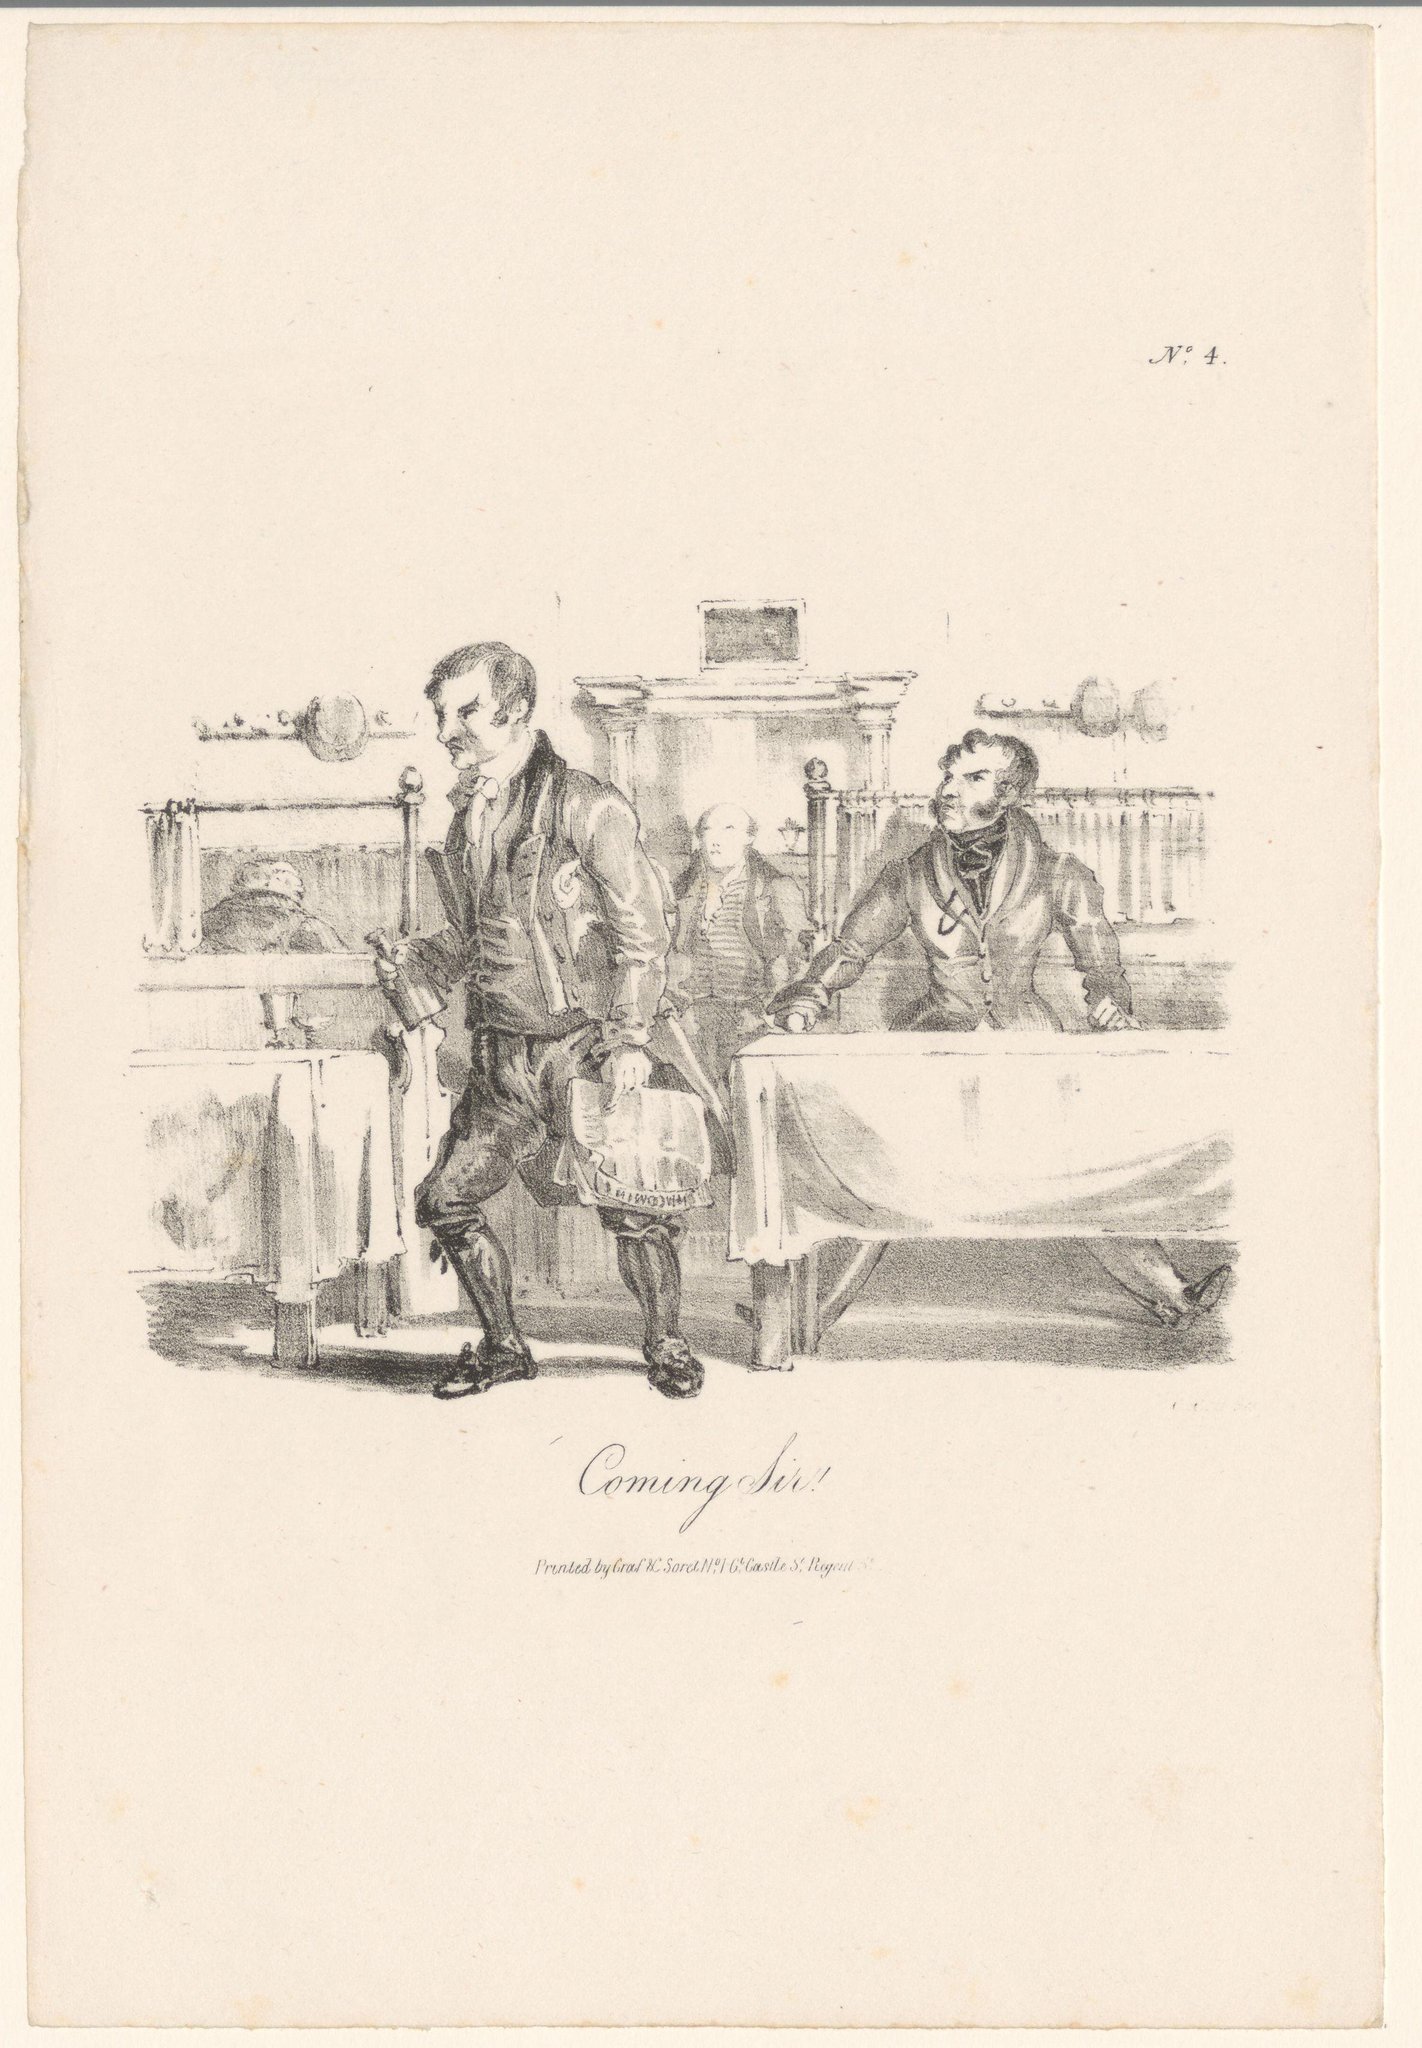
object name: cartoon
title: Diverse spotprenten over de Engelse bevolking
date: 1830-1838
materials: paper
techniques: lithograph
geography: london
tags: container of glass: bottle, jar, vase, restaurant, newspaper, news-sheet, political caricatures and satires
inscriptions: collector's mark: Lugt 2228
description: Prent maakt deel uit van een serie met spotprenten. Over deze serie is verder niets bekend. Het betreft voornamelijk voorstellingen over de Engelse bevolking.